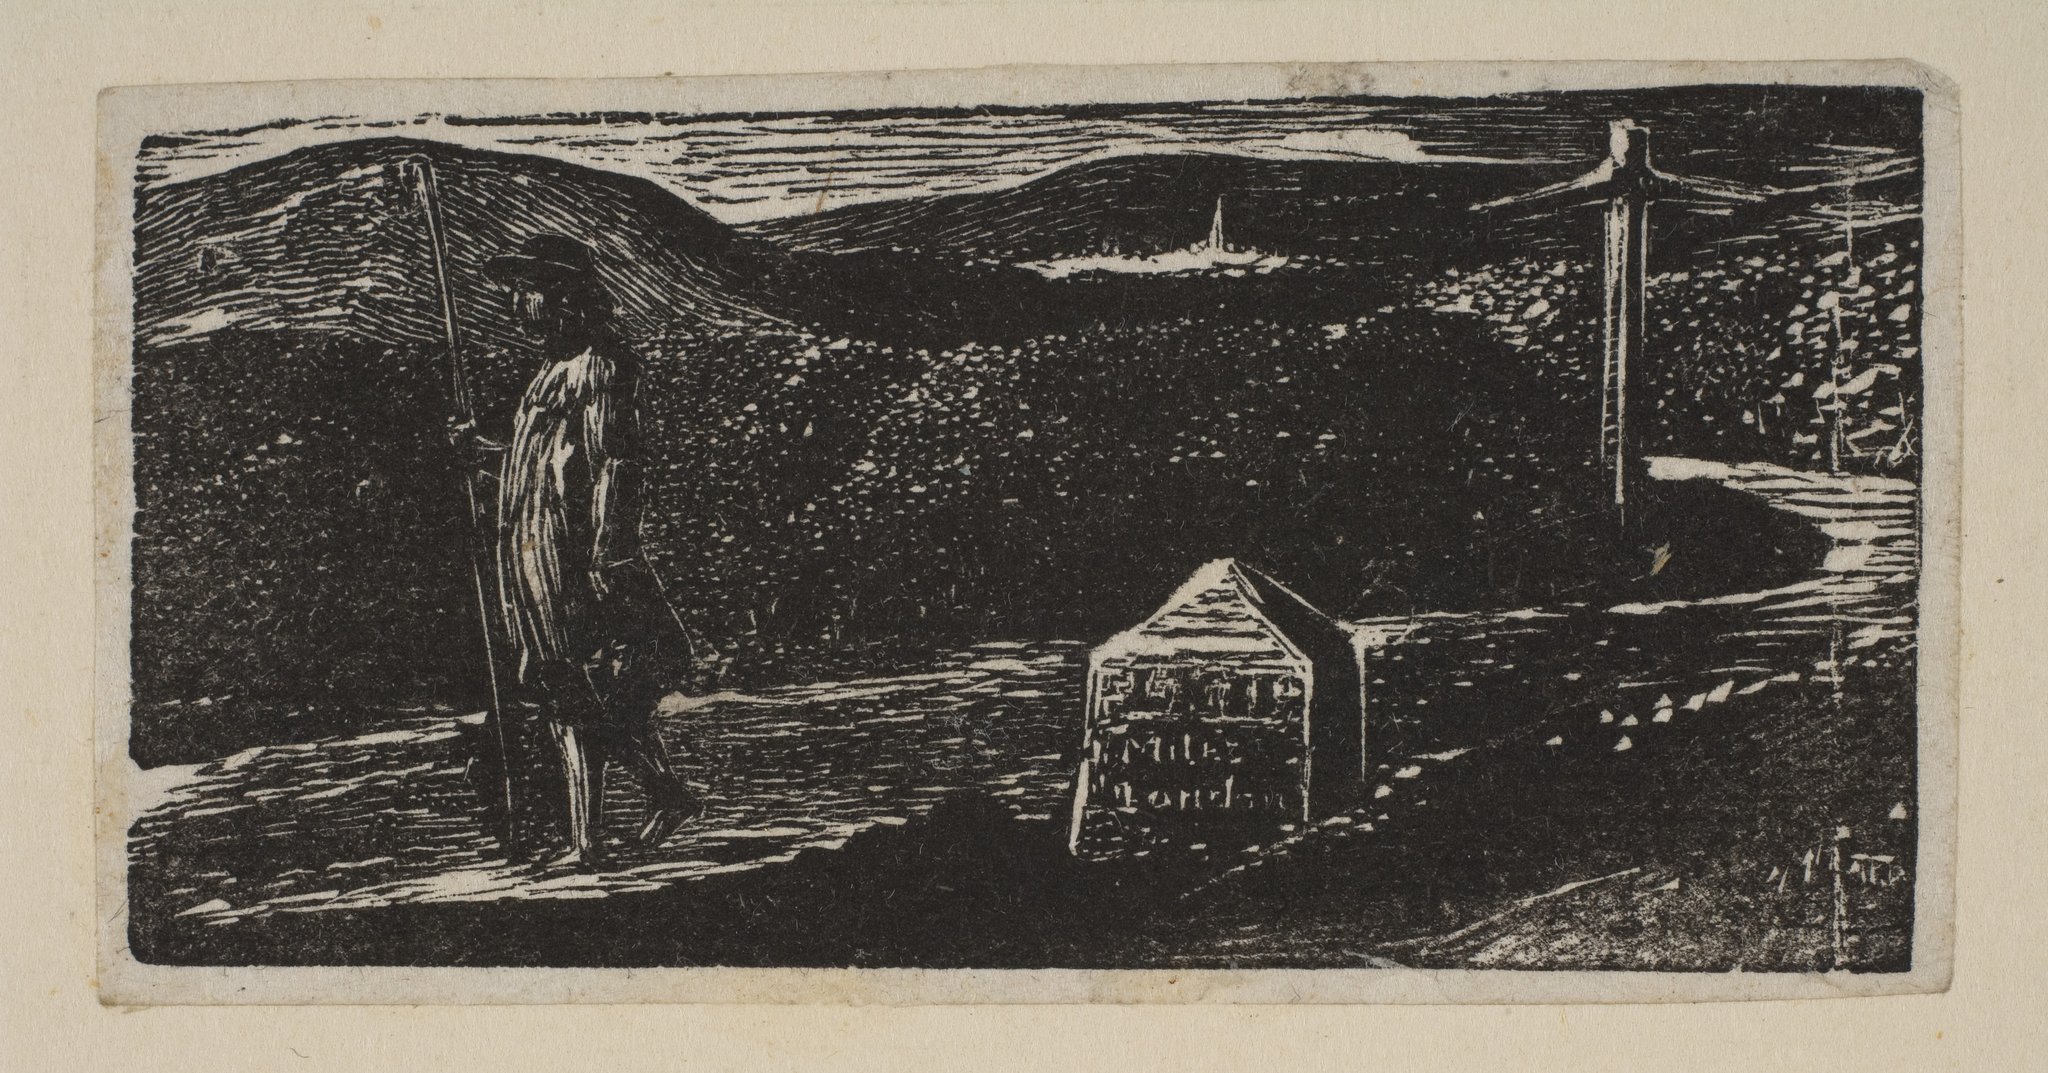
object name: print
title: Colinet's Journey, Milestone Marked 'LXII Miles to London', from Thornton's "Pastorals of Virgil"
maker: william blake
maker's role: artist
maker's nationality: british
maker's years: 1757-1827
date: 1821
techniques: engraving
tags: roads,men